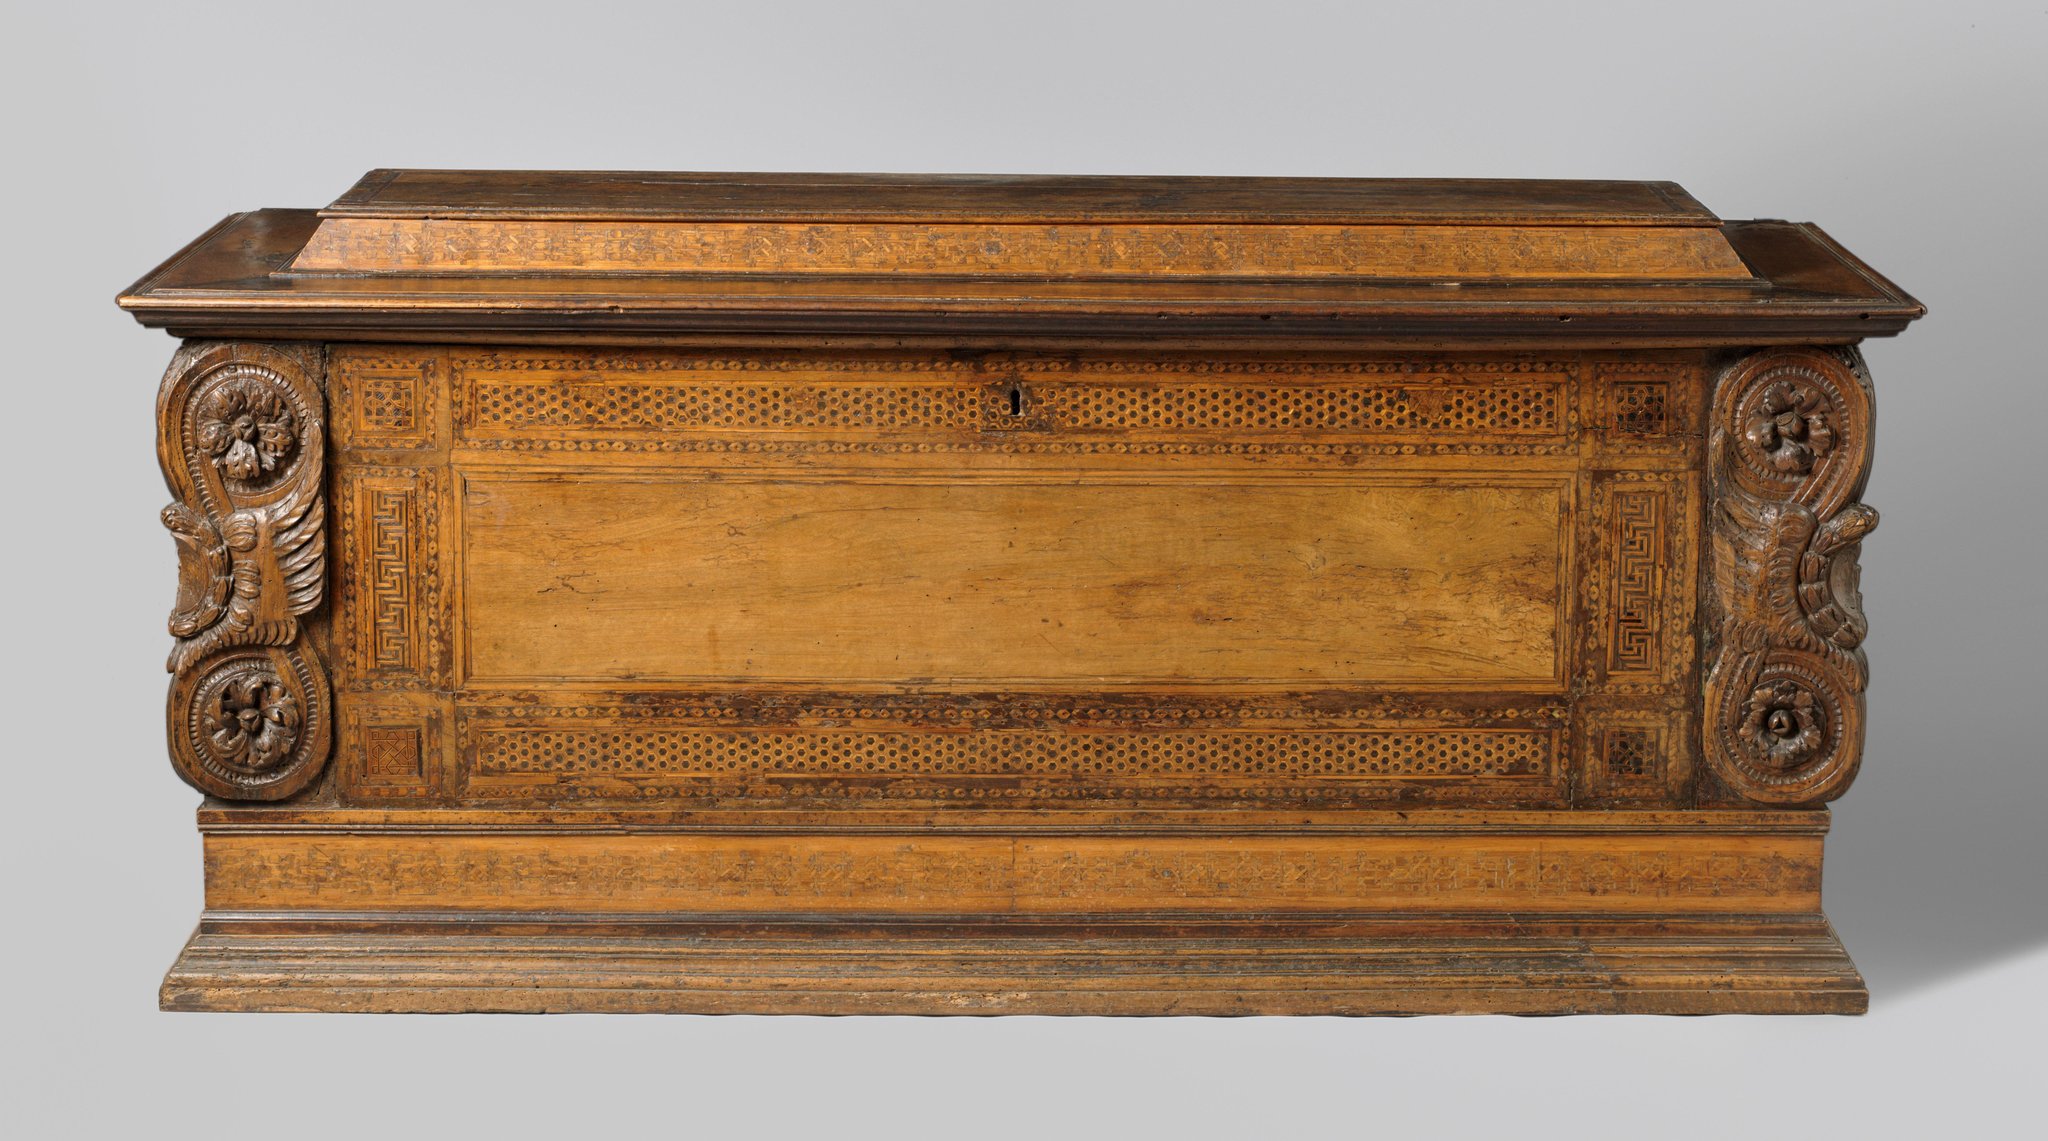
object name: furniture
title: Cassone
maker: Anonymous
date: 1500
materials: wood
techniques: intarsia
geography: florence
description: Kist van notenhout met binnenwerk van populierenhout, versierd met intarsia in verschillende houtsoorten. De kist rust op een geprofileerde plint, waarboven een brede band met motieven in intarsia. De diagonaal geplaatste hoekstijlen hebben de vorm van S-voluten en zijn versierd met rozetten en een hol schild met brede vleugels en bloemkrans. Voor- en zijkanten zijn omlijst met motieven in intarsia evenals de vlakke deksel die aan de binnenkant een hol kussen draagt.